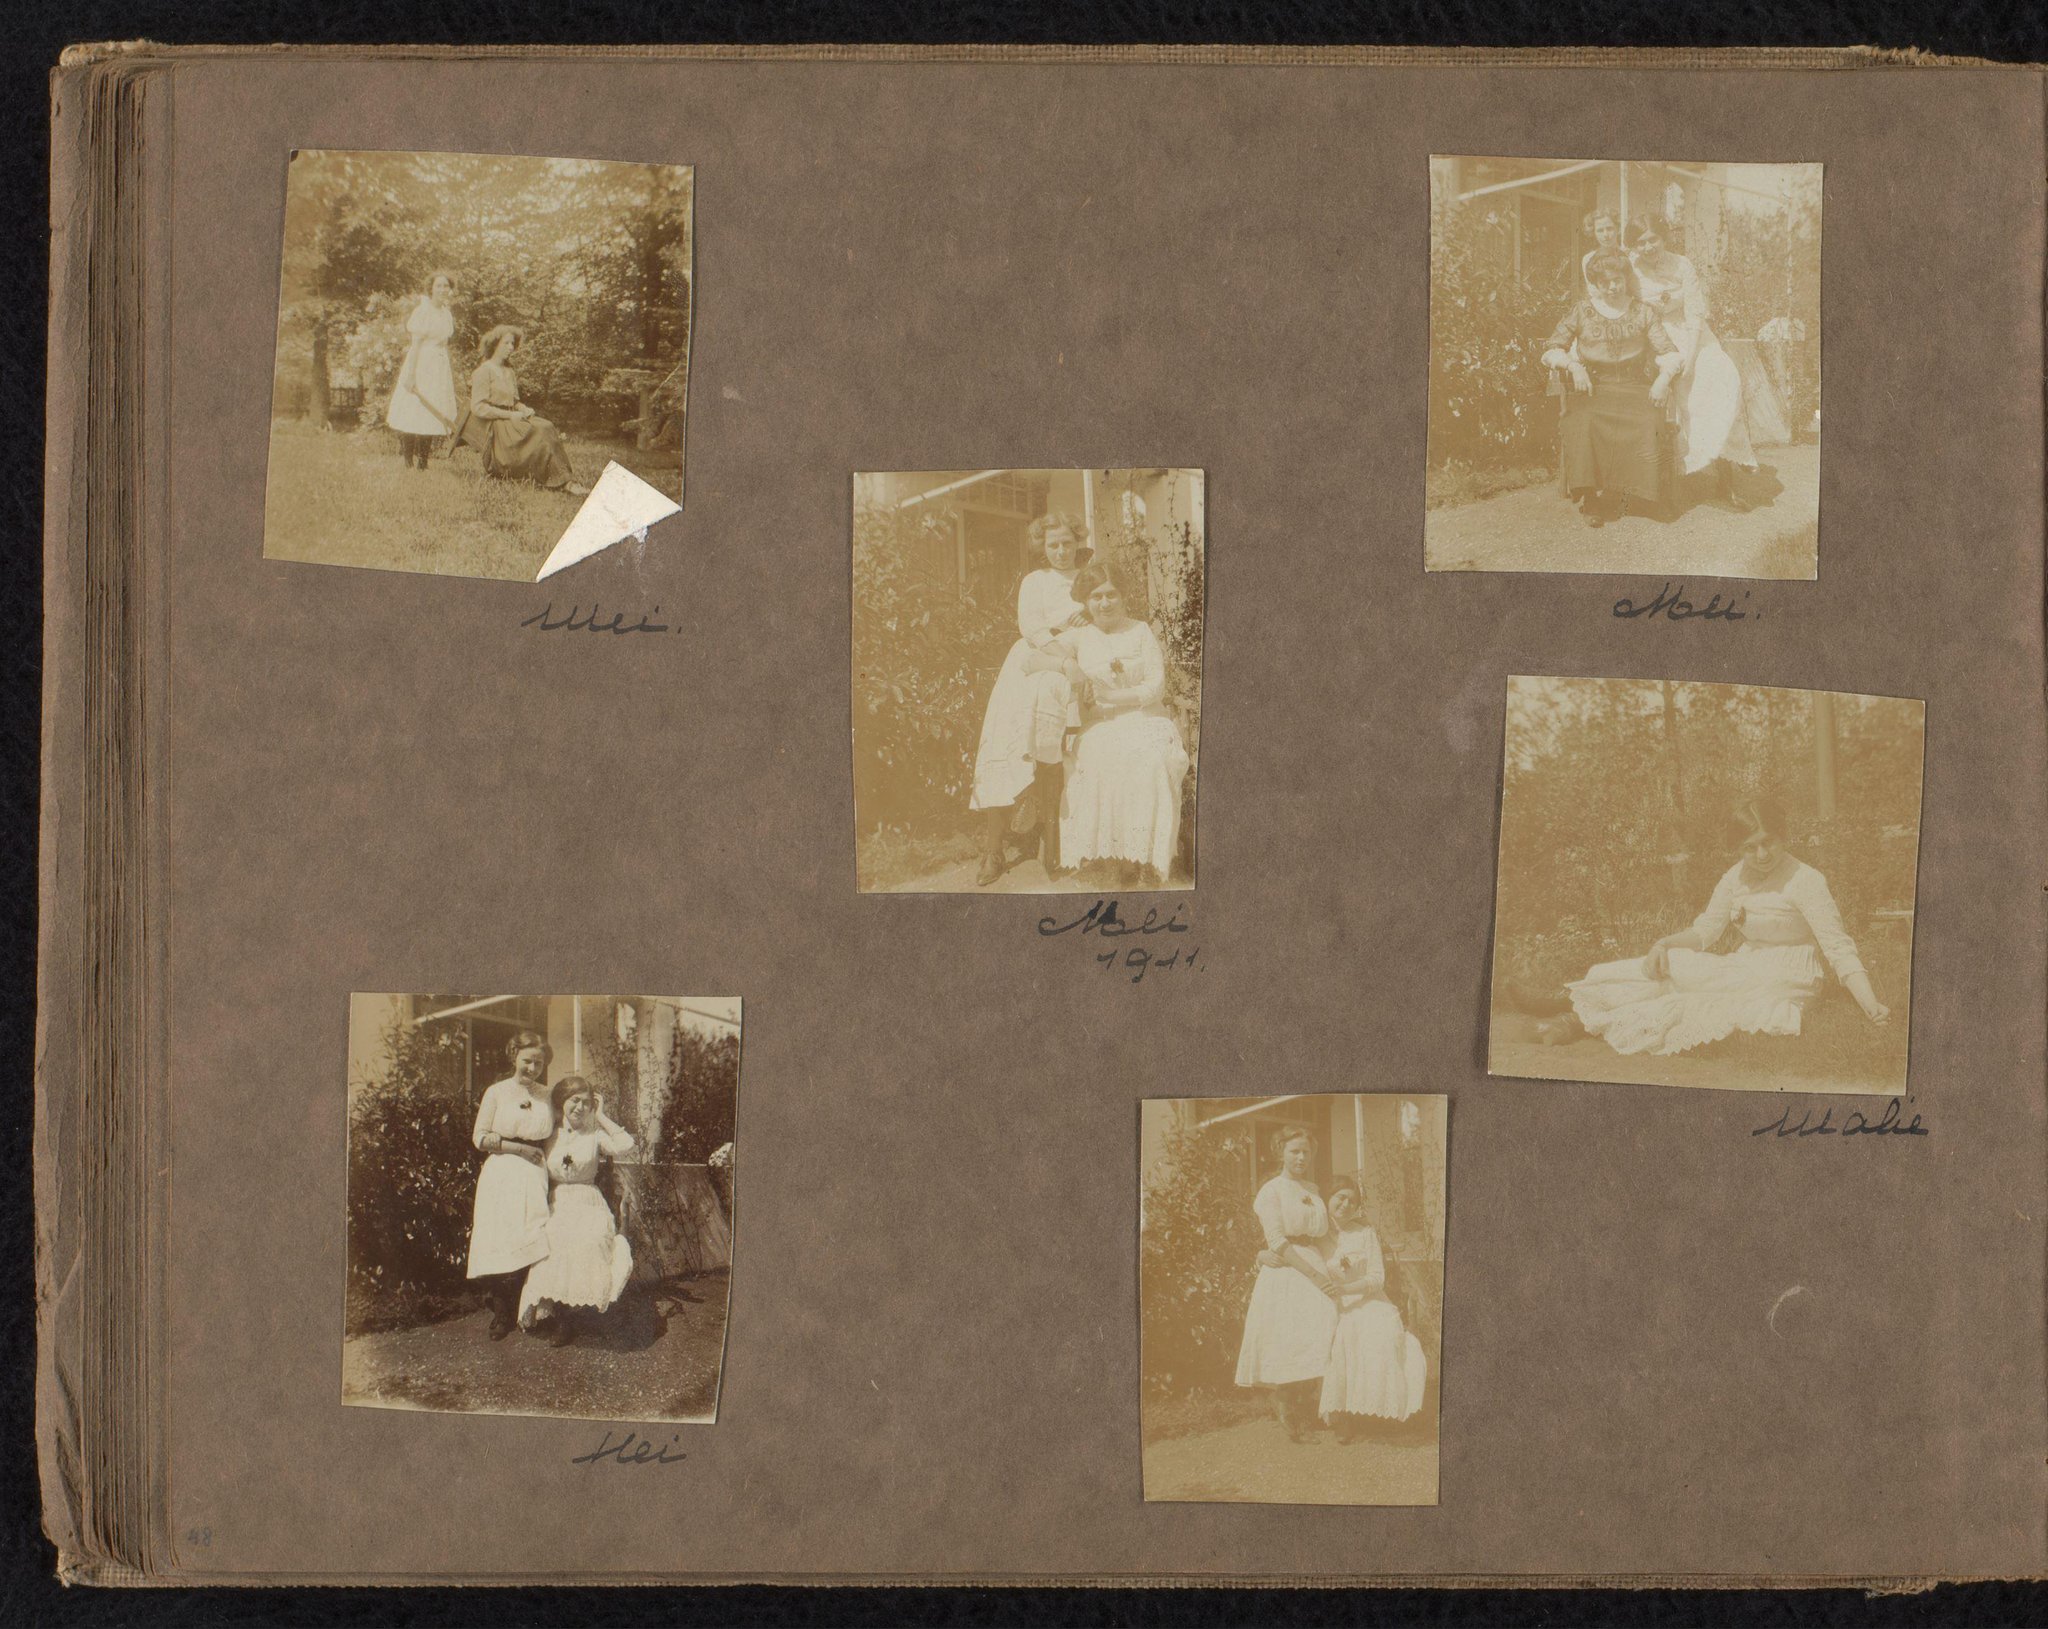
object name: photograph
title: Zes foto's van Loentje Onnen met vriendinnen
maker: carolina frederika onnen (lien/loen)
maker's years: 1896-1983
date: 1905-1911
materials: paper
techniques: gelatin silver print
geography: hilversum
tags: amsterdam, carolina frederika onnen (lien/loen), historical persons - bb - woman, friends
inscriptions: inscription: ‘Mei’, inscription: ‘Mei’, inscription: ‘Malie’, inscription: ‘Mei/ 1911’, inscription: ‘Mei’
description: Deze foto's maken deel uit van een album.